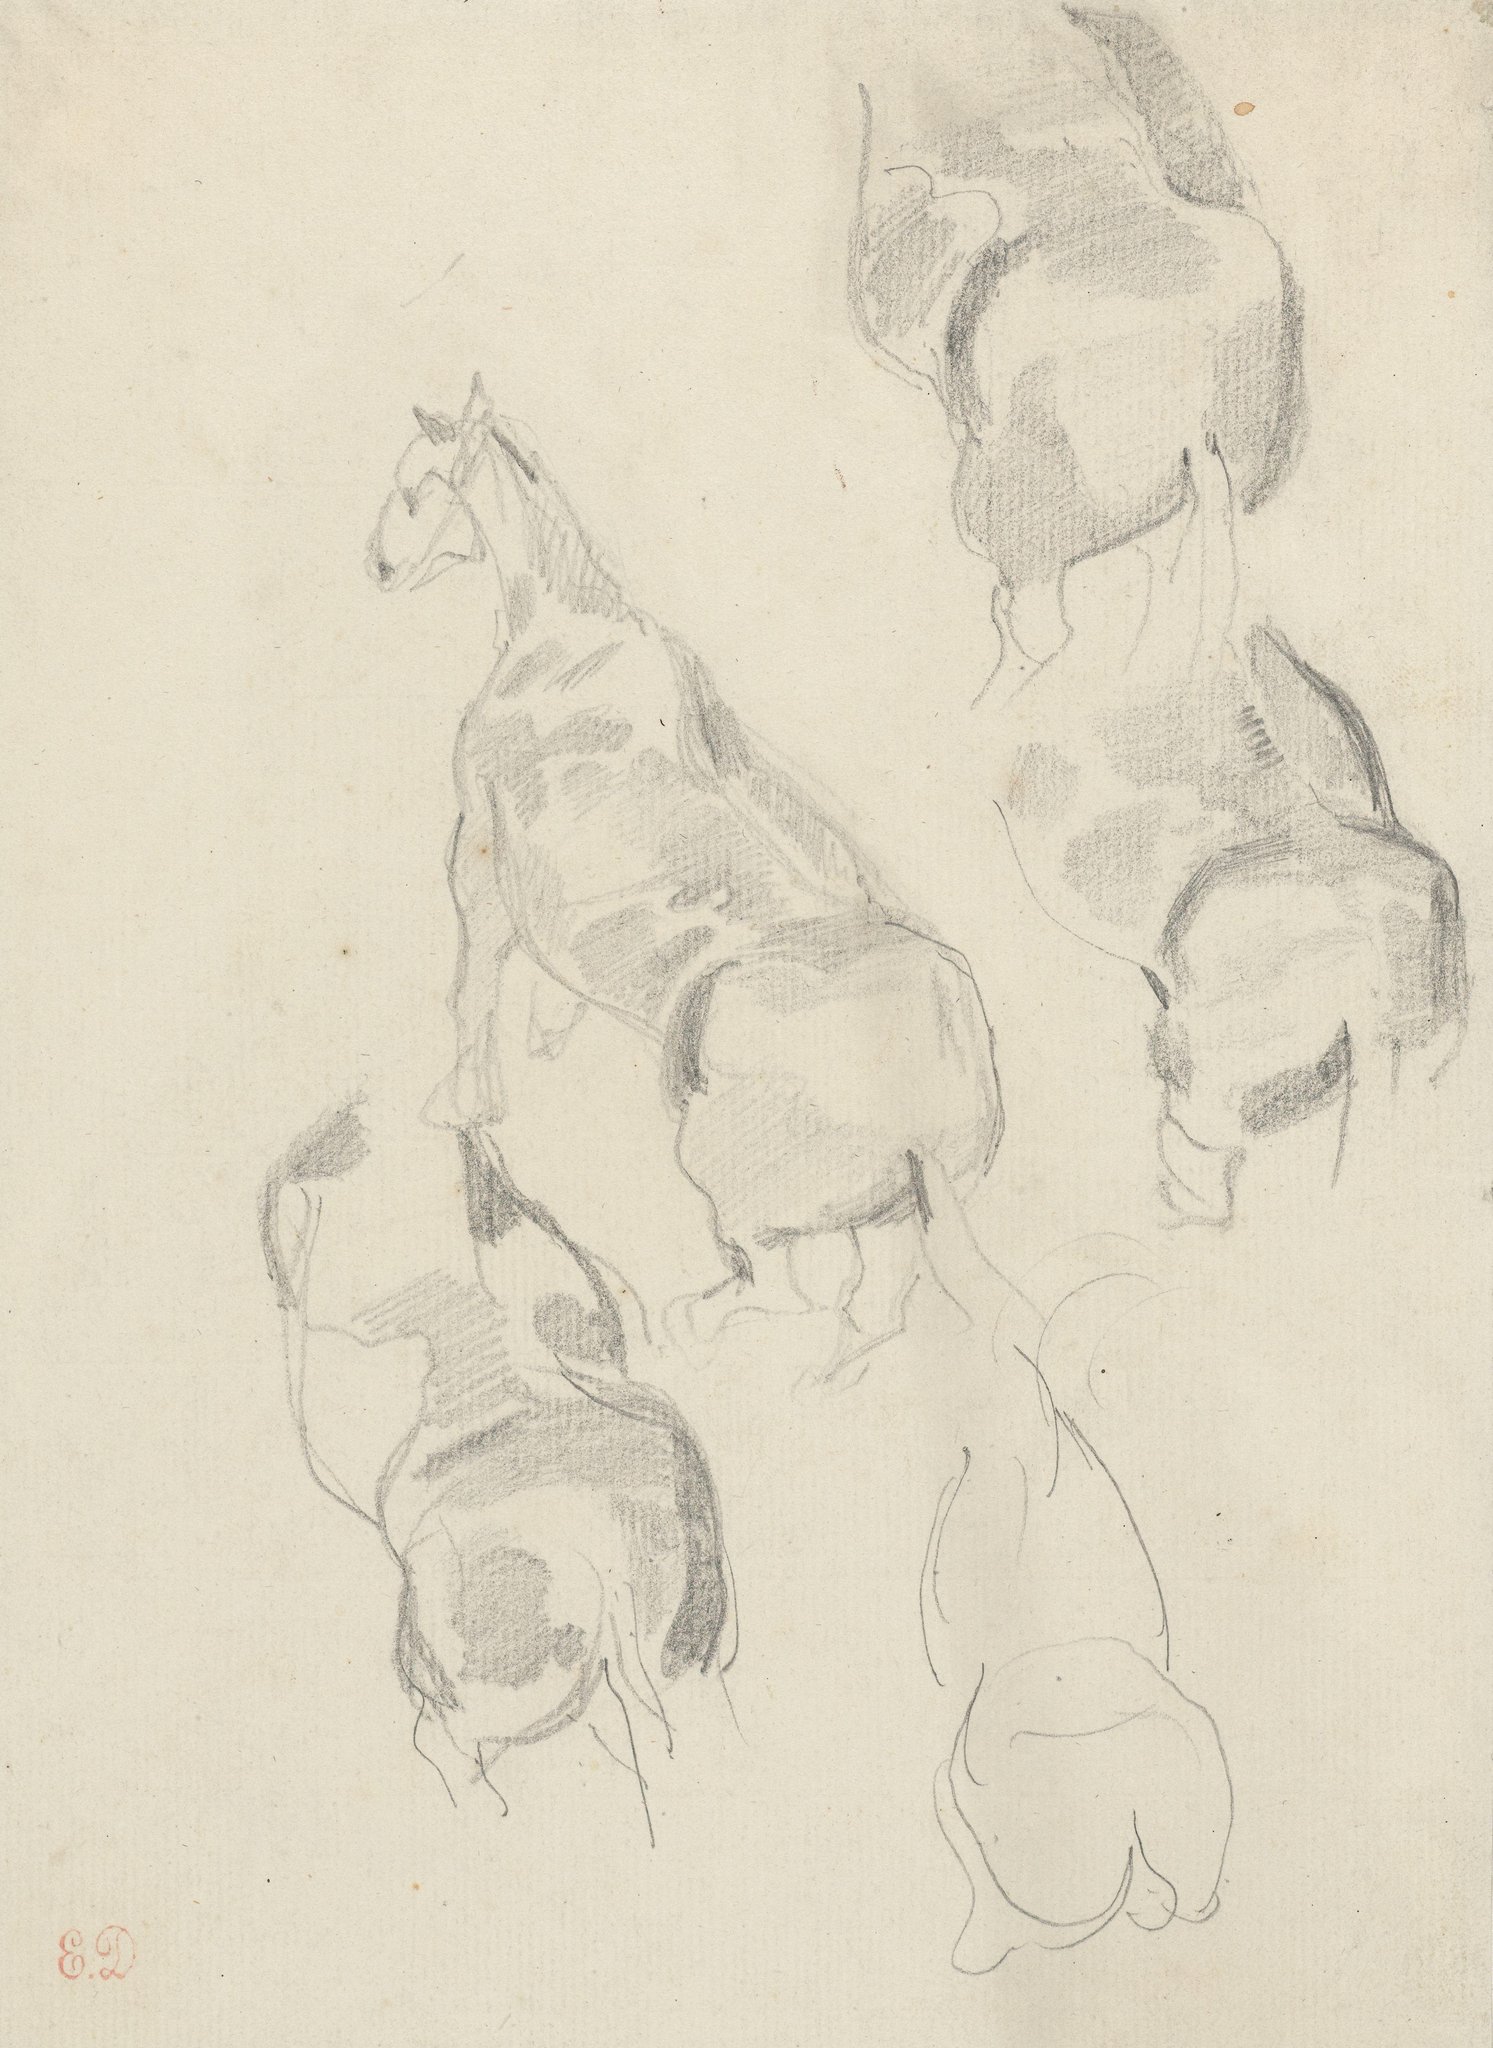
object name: drawing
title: Vijf studies van een paard, uit een raam gezien, schuin van achteren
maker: eugène delacroix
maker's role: draughtsman, print maker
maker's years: 1798-1863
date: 1808-1863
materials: paper, pencil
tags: horse